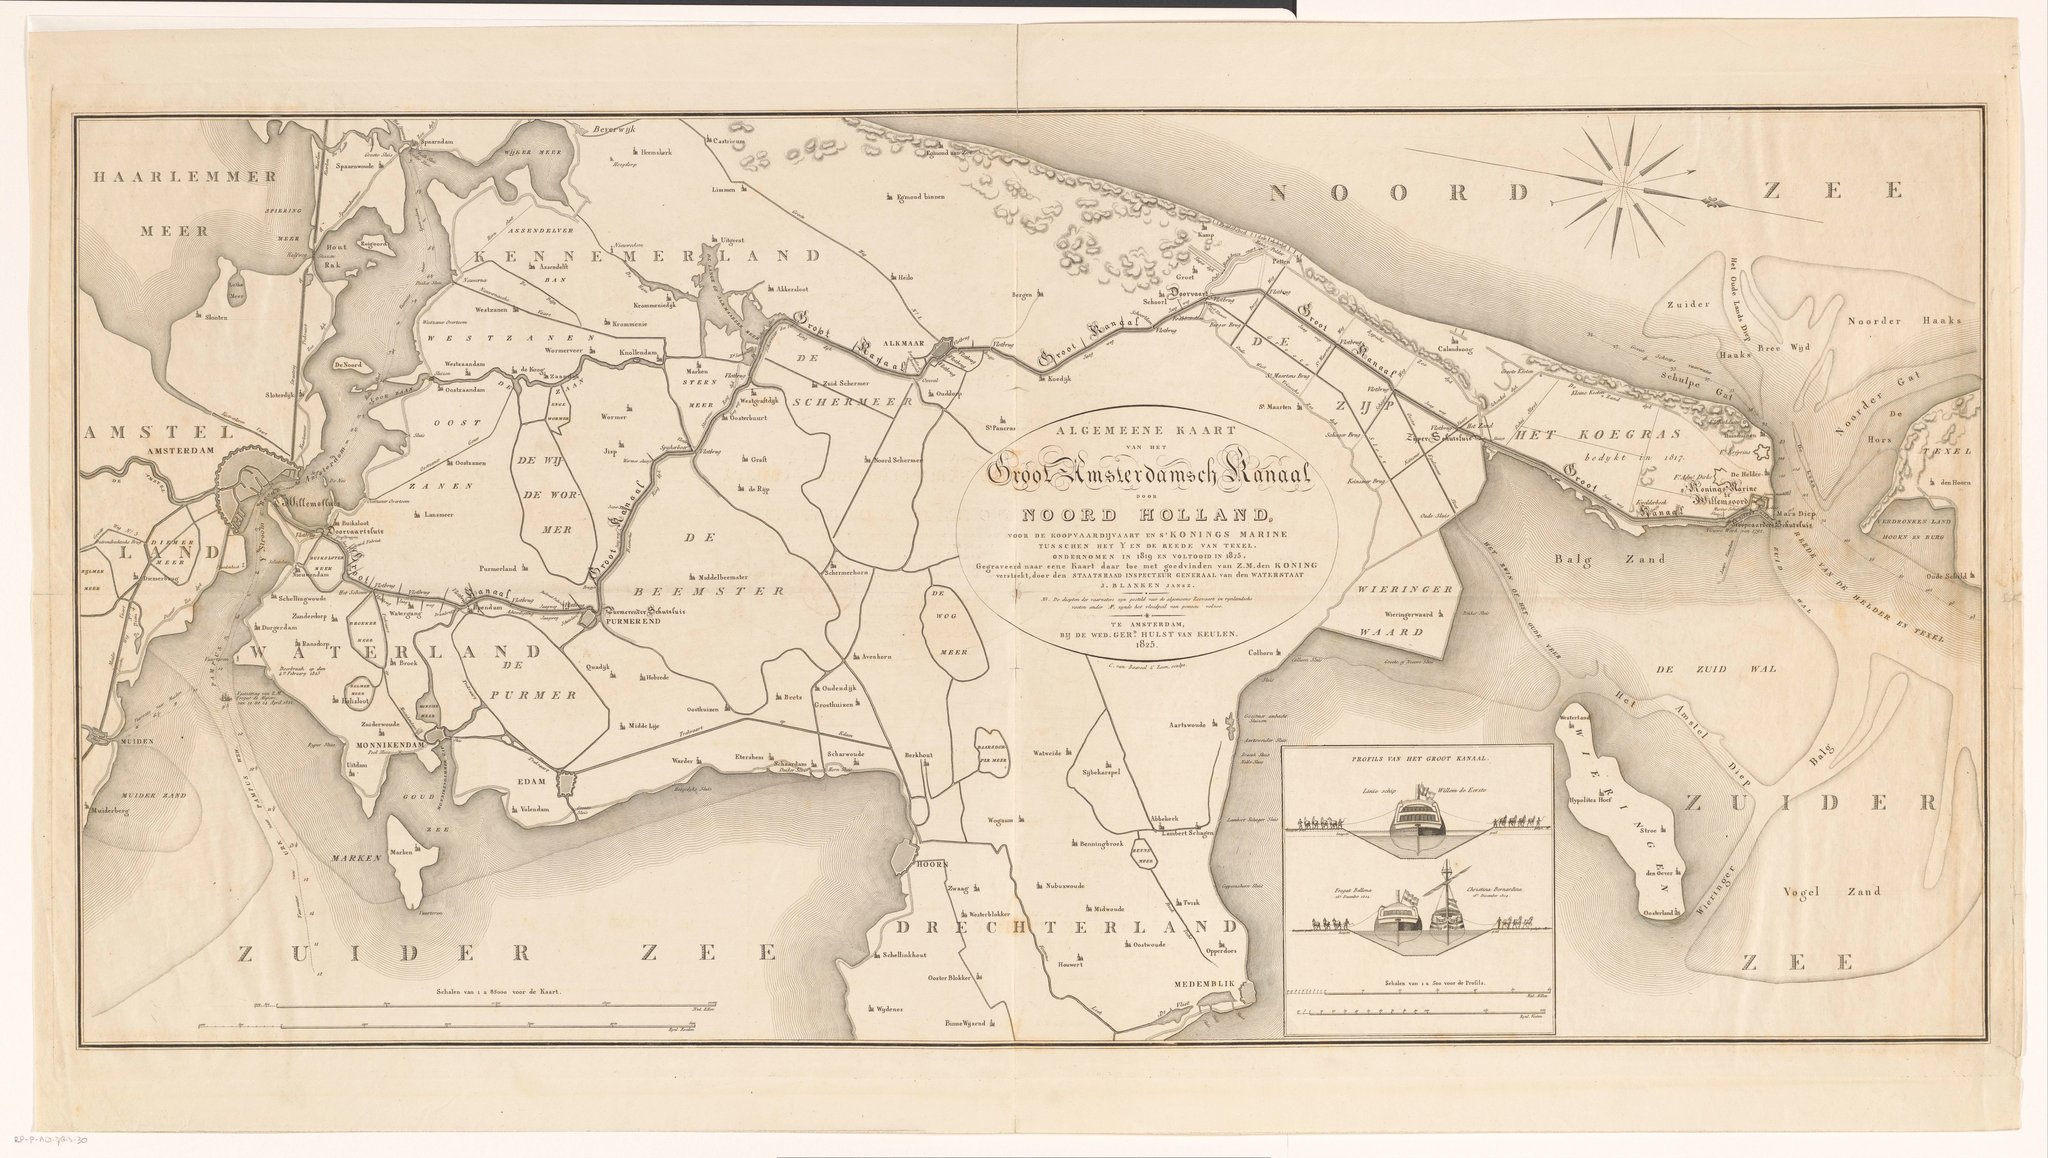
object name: print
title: Kaart van het Noordhollandsch Kanaal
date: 1825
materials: paper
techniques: engraving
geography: amsterdam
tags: maps of separate countries or regions, canal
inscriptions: collector's mark: Lugt 19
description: Kaart van het Noordhollandsch Kanaal, dat tussen 1819 en 1825 werd aangelegd tussen Amsterdam en Den Helder. Linksonder twee schaalstokken: Schalen van 1 a 85000 voor de kaart. In het midden de titelcartouche, rechtsonder daarvan een inzet met twee profielen van het kanaal en twee eigen schaalstokken: Schalen van 1 a 500 voor de profils. Oriëntatie: noorden rechts.